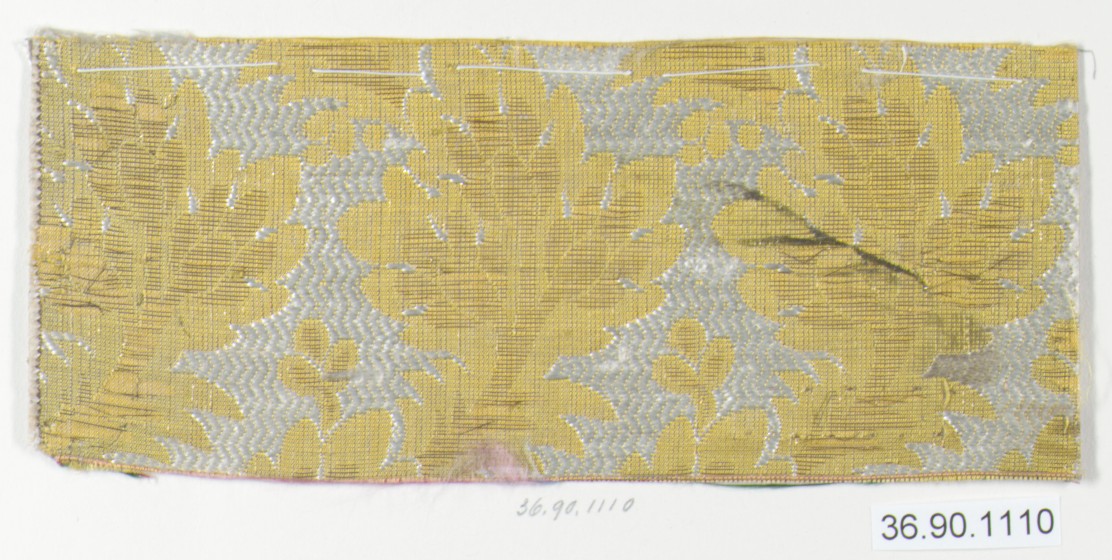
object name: sample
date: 1701-1900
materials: metal thread, silk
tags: leaves